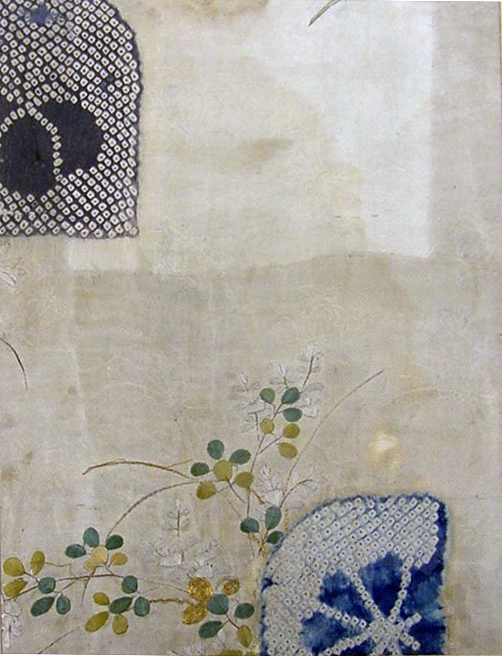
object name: piece from a kosode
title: Piece from a Kosode with "Bush Clover" (hagi) and Fan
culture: japanese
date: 1615-1868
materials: metal thread, silk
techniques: damask, dyeing, embroidery, resist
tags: plants